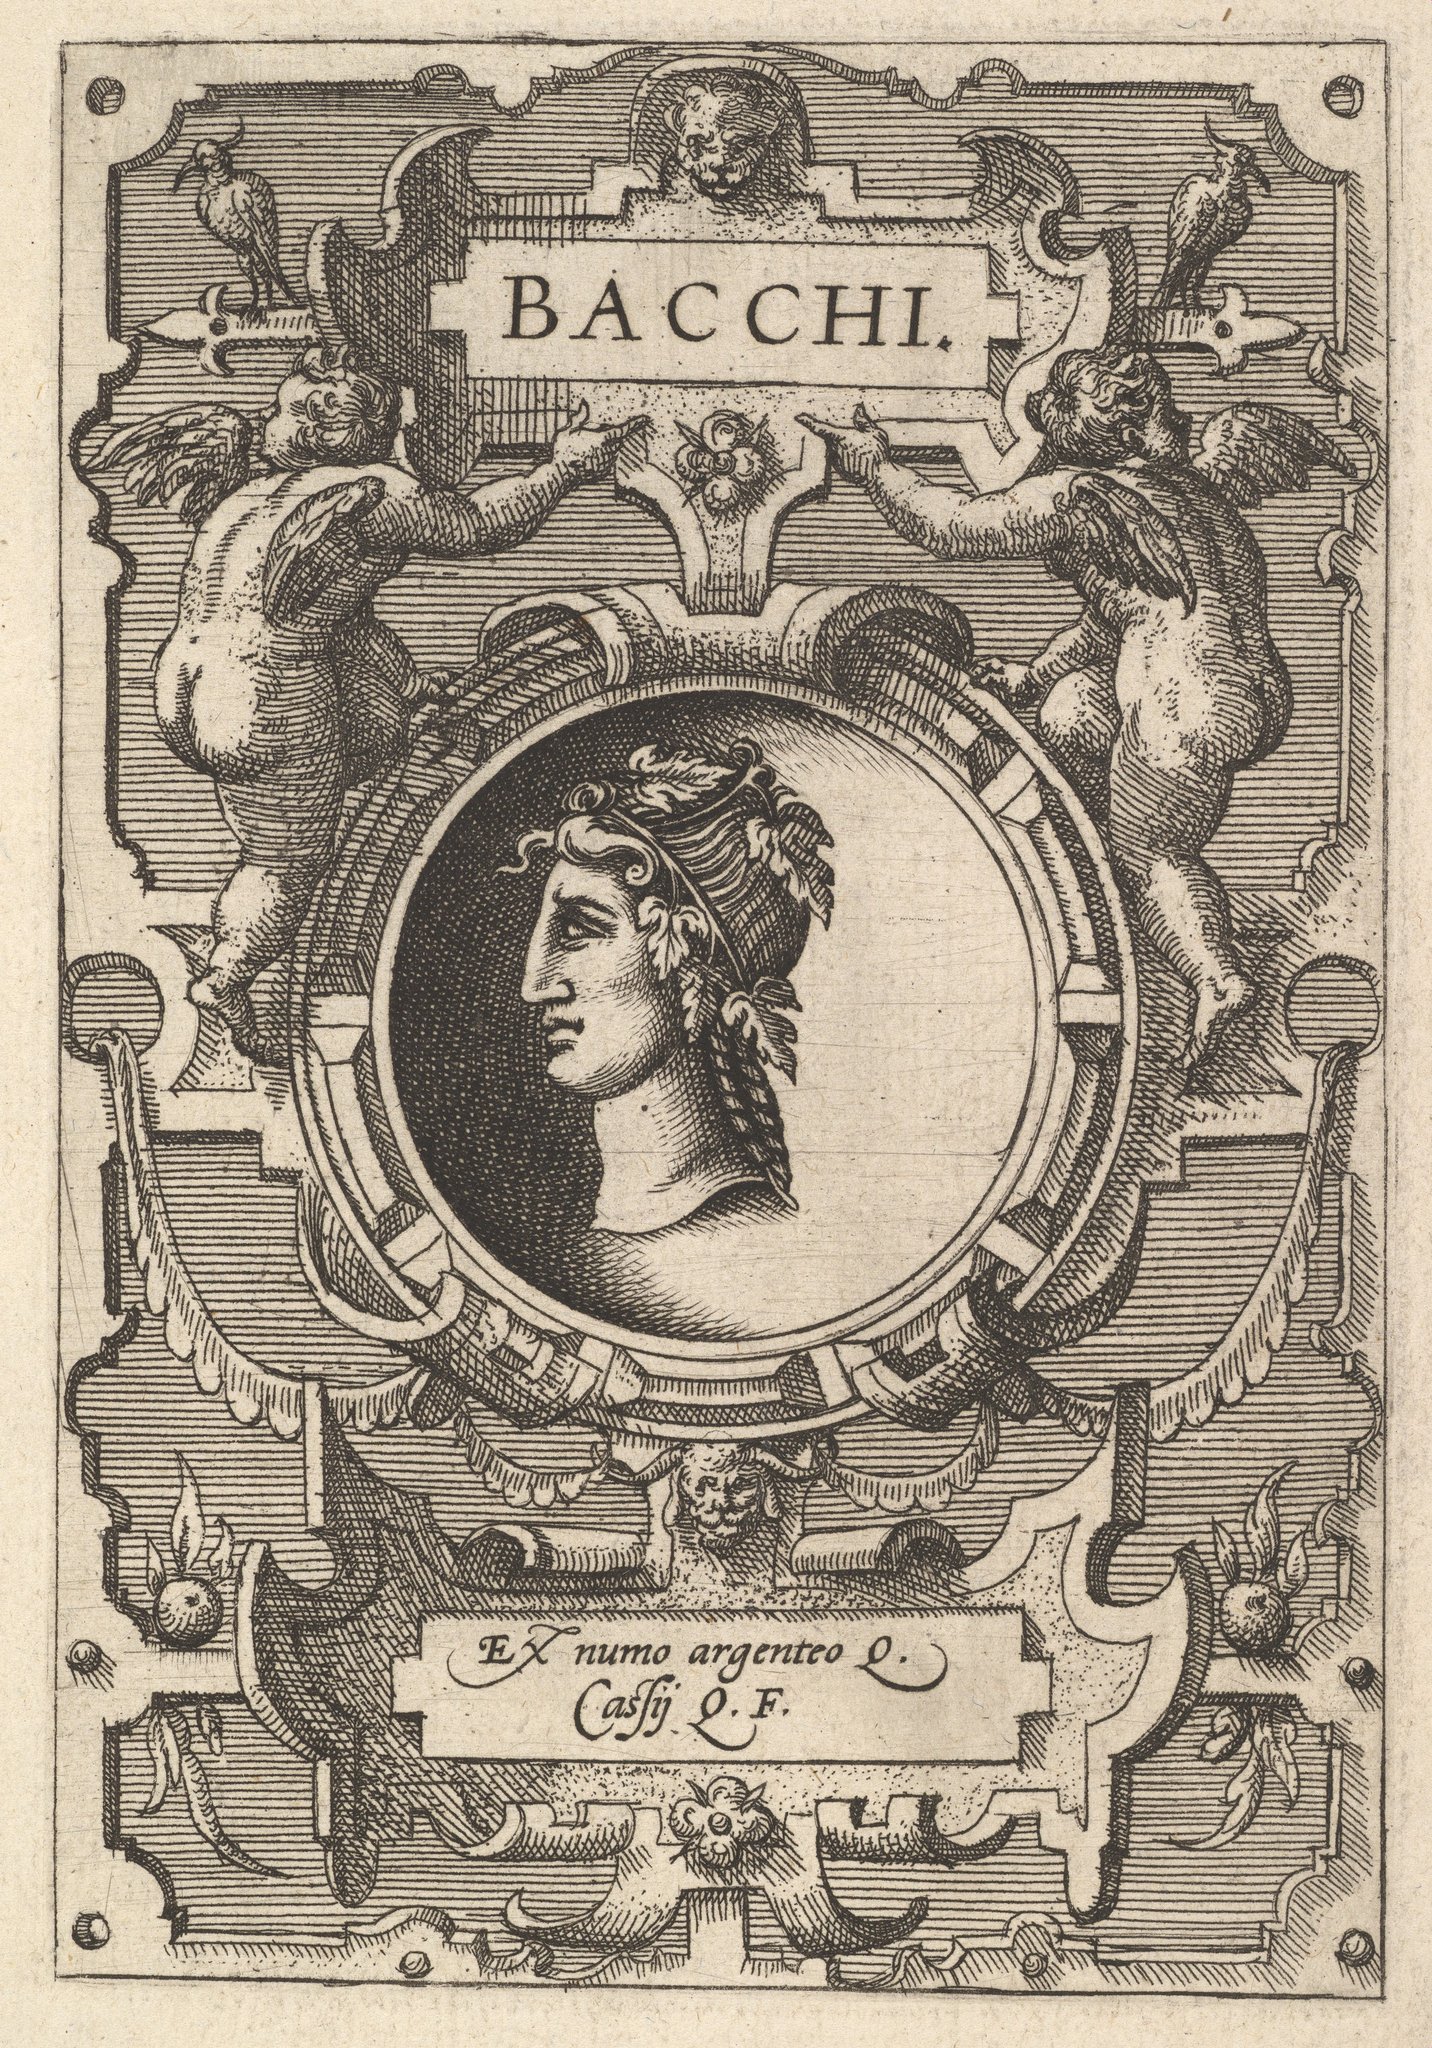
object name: print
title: Bust of Bacchus surrounded by strapwork, from "Deorum dearumque"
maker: gerard van groeningen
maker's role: artist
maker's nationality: netherlandish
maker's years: 1563-1573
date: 1573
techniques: etching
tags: profiles,bacchus